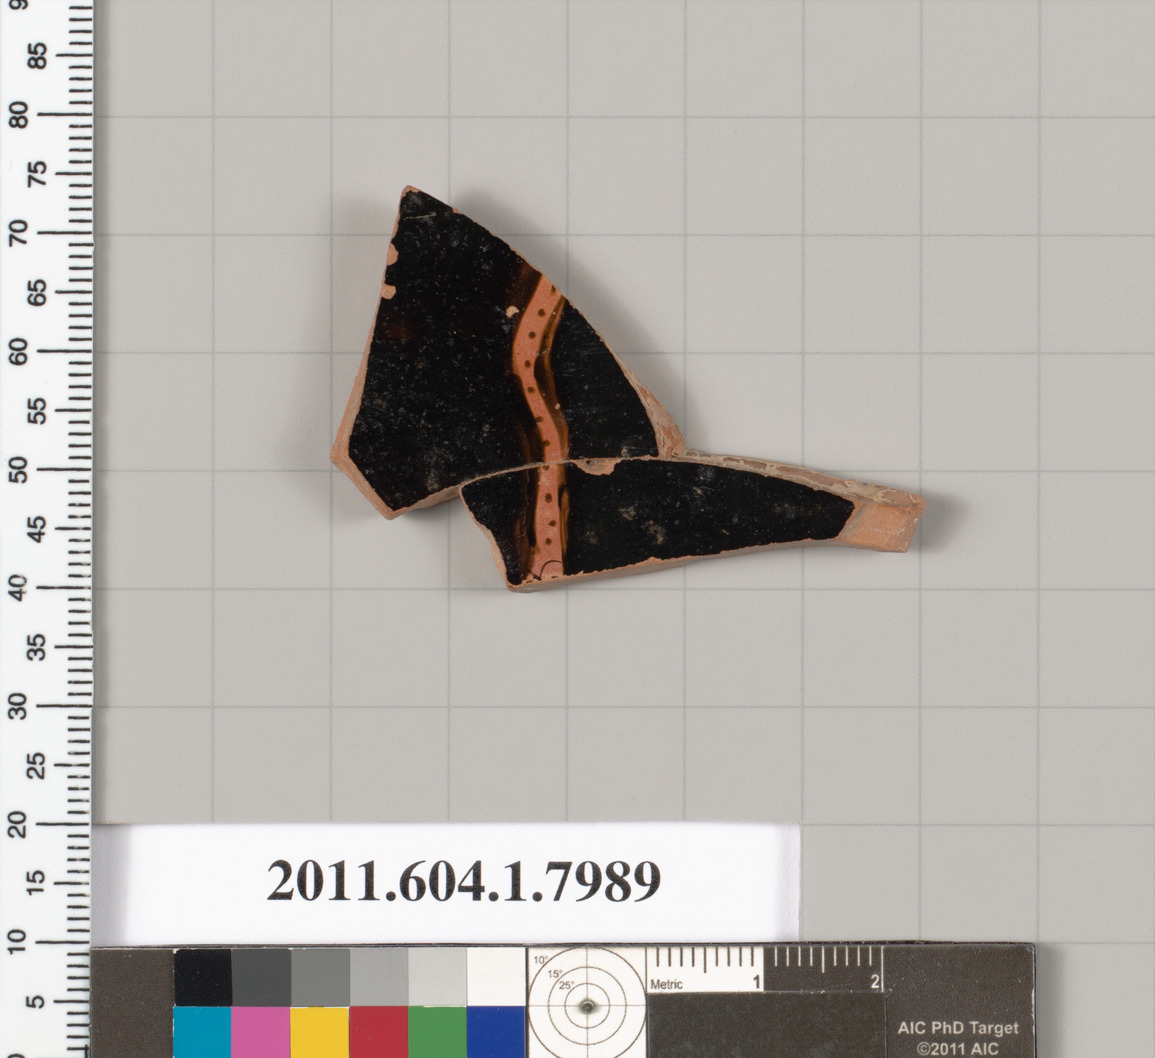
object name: kylix fragment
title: Terracotta fragment of a kylix (drinking cup)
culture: greek, attic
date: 460-450 BCE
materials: terracotta